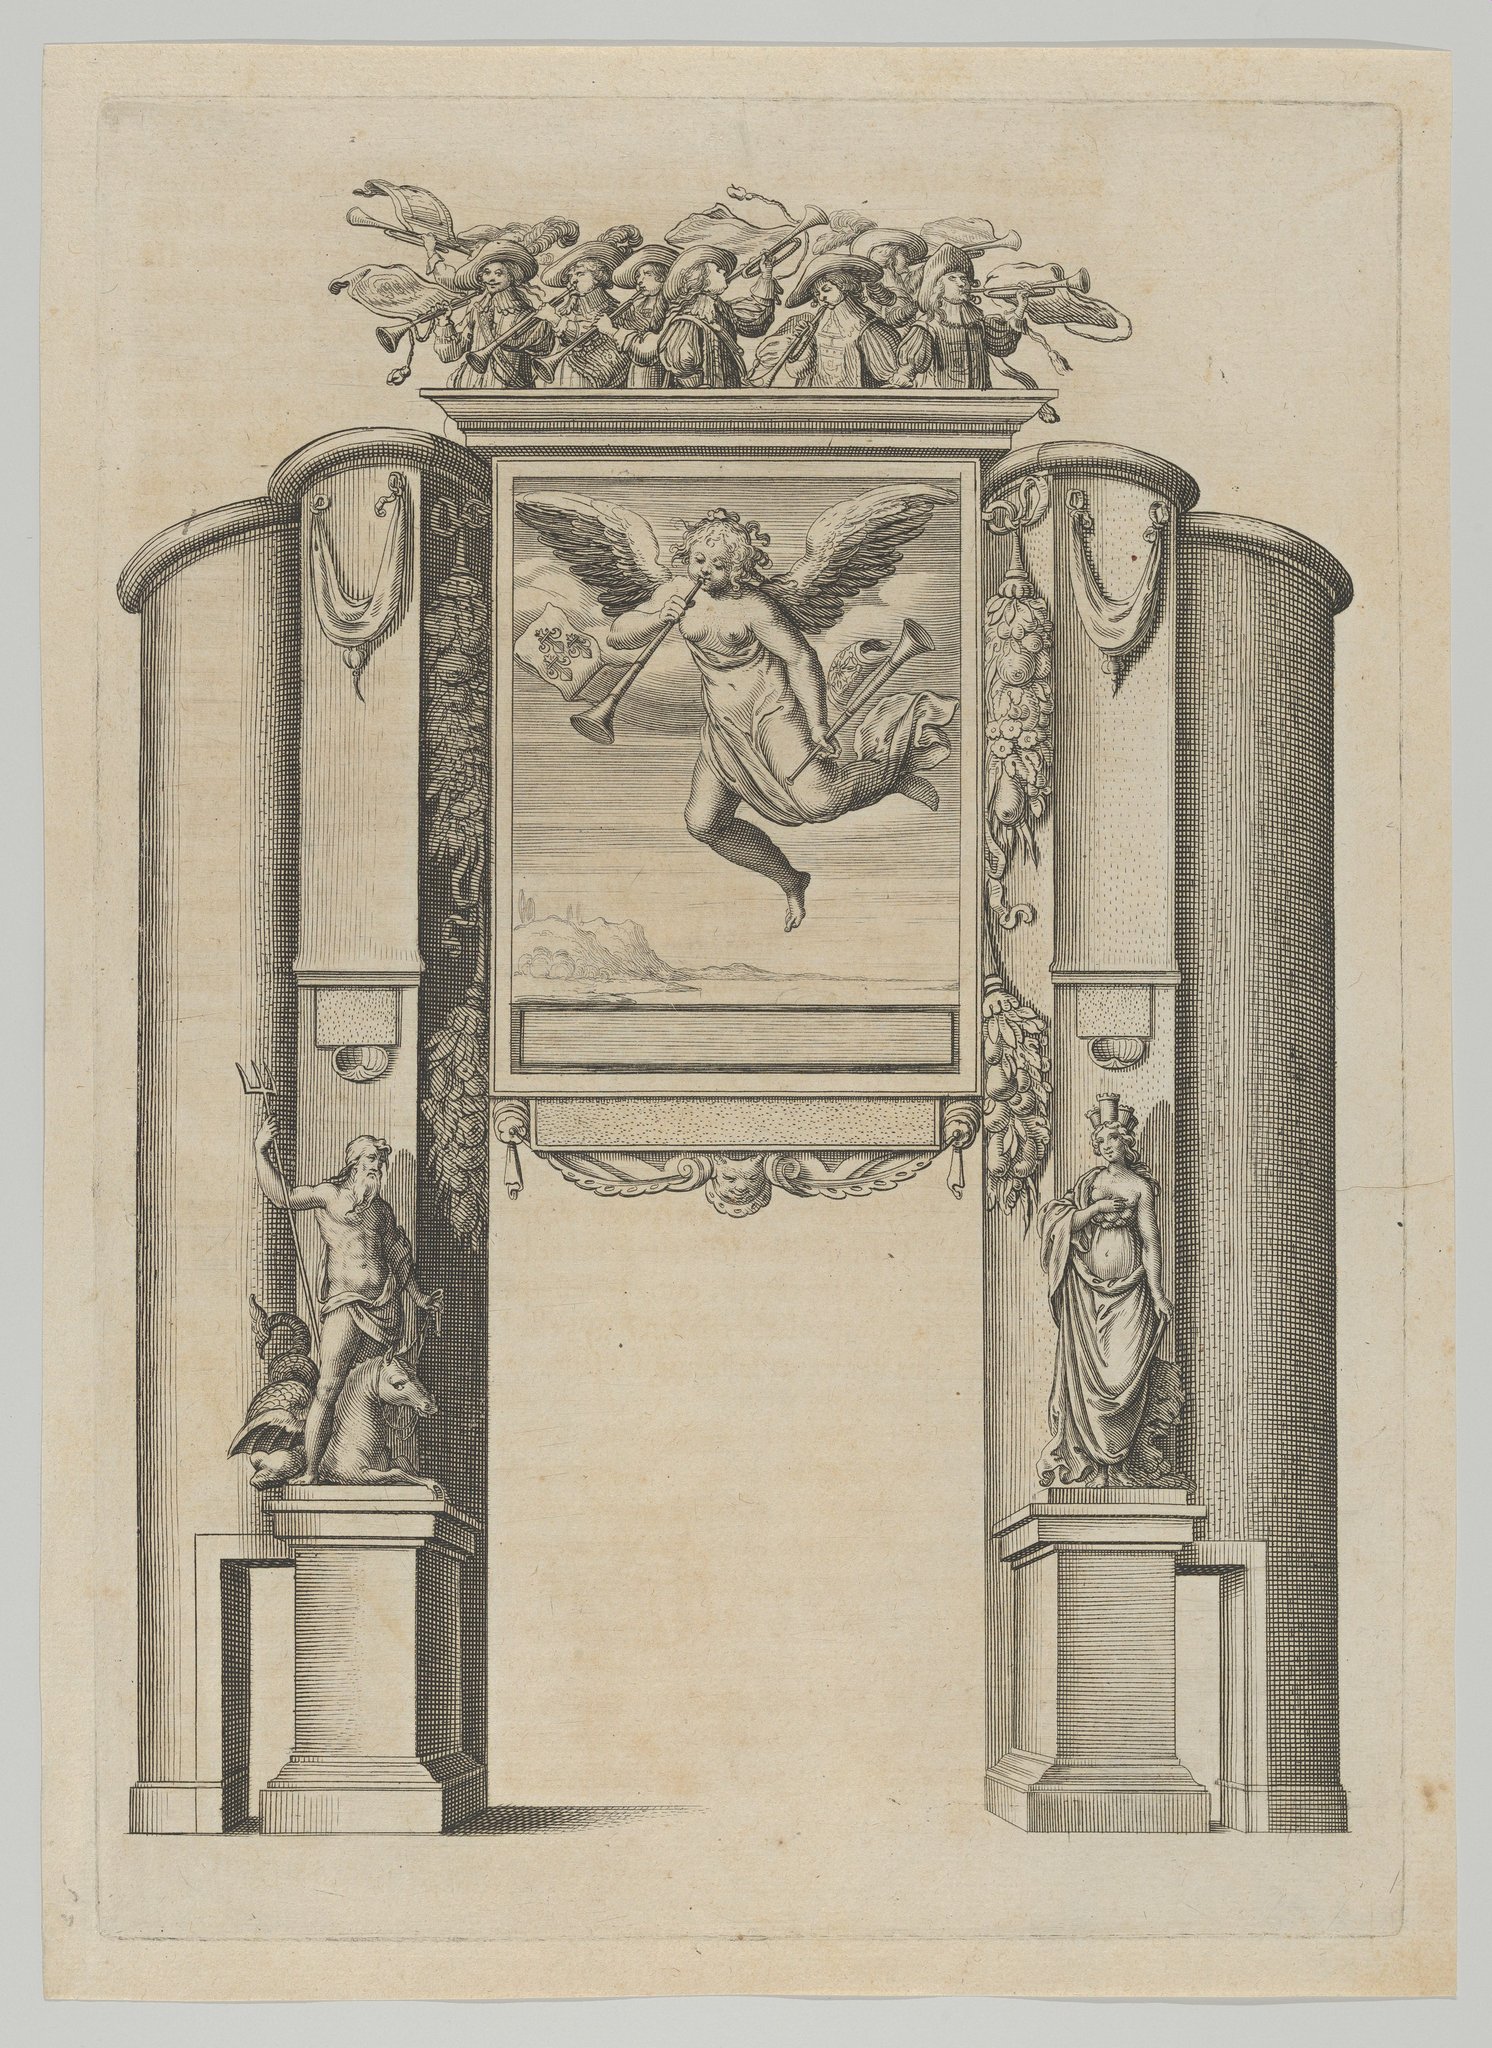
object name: print, fete, ornament architecture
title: Triumphal arch, from 'Éloges et discours sur la triomphante réception du Roy en sa ville de Paris ...' by Jean-Baptiste de Machault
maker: melchior tavernier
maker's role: artist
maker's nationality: french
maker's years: 1564-1641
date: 1629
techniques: etching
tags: men,women,trumpets